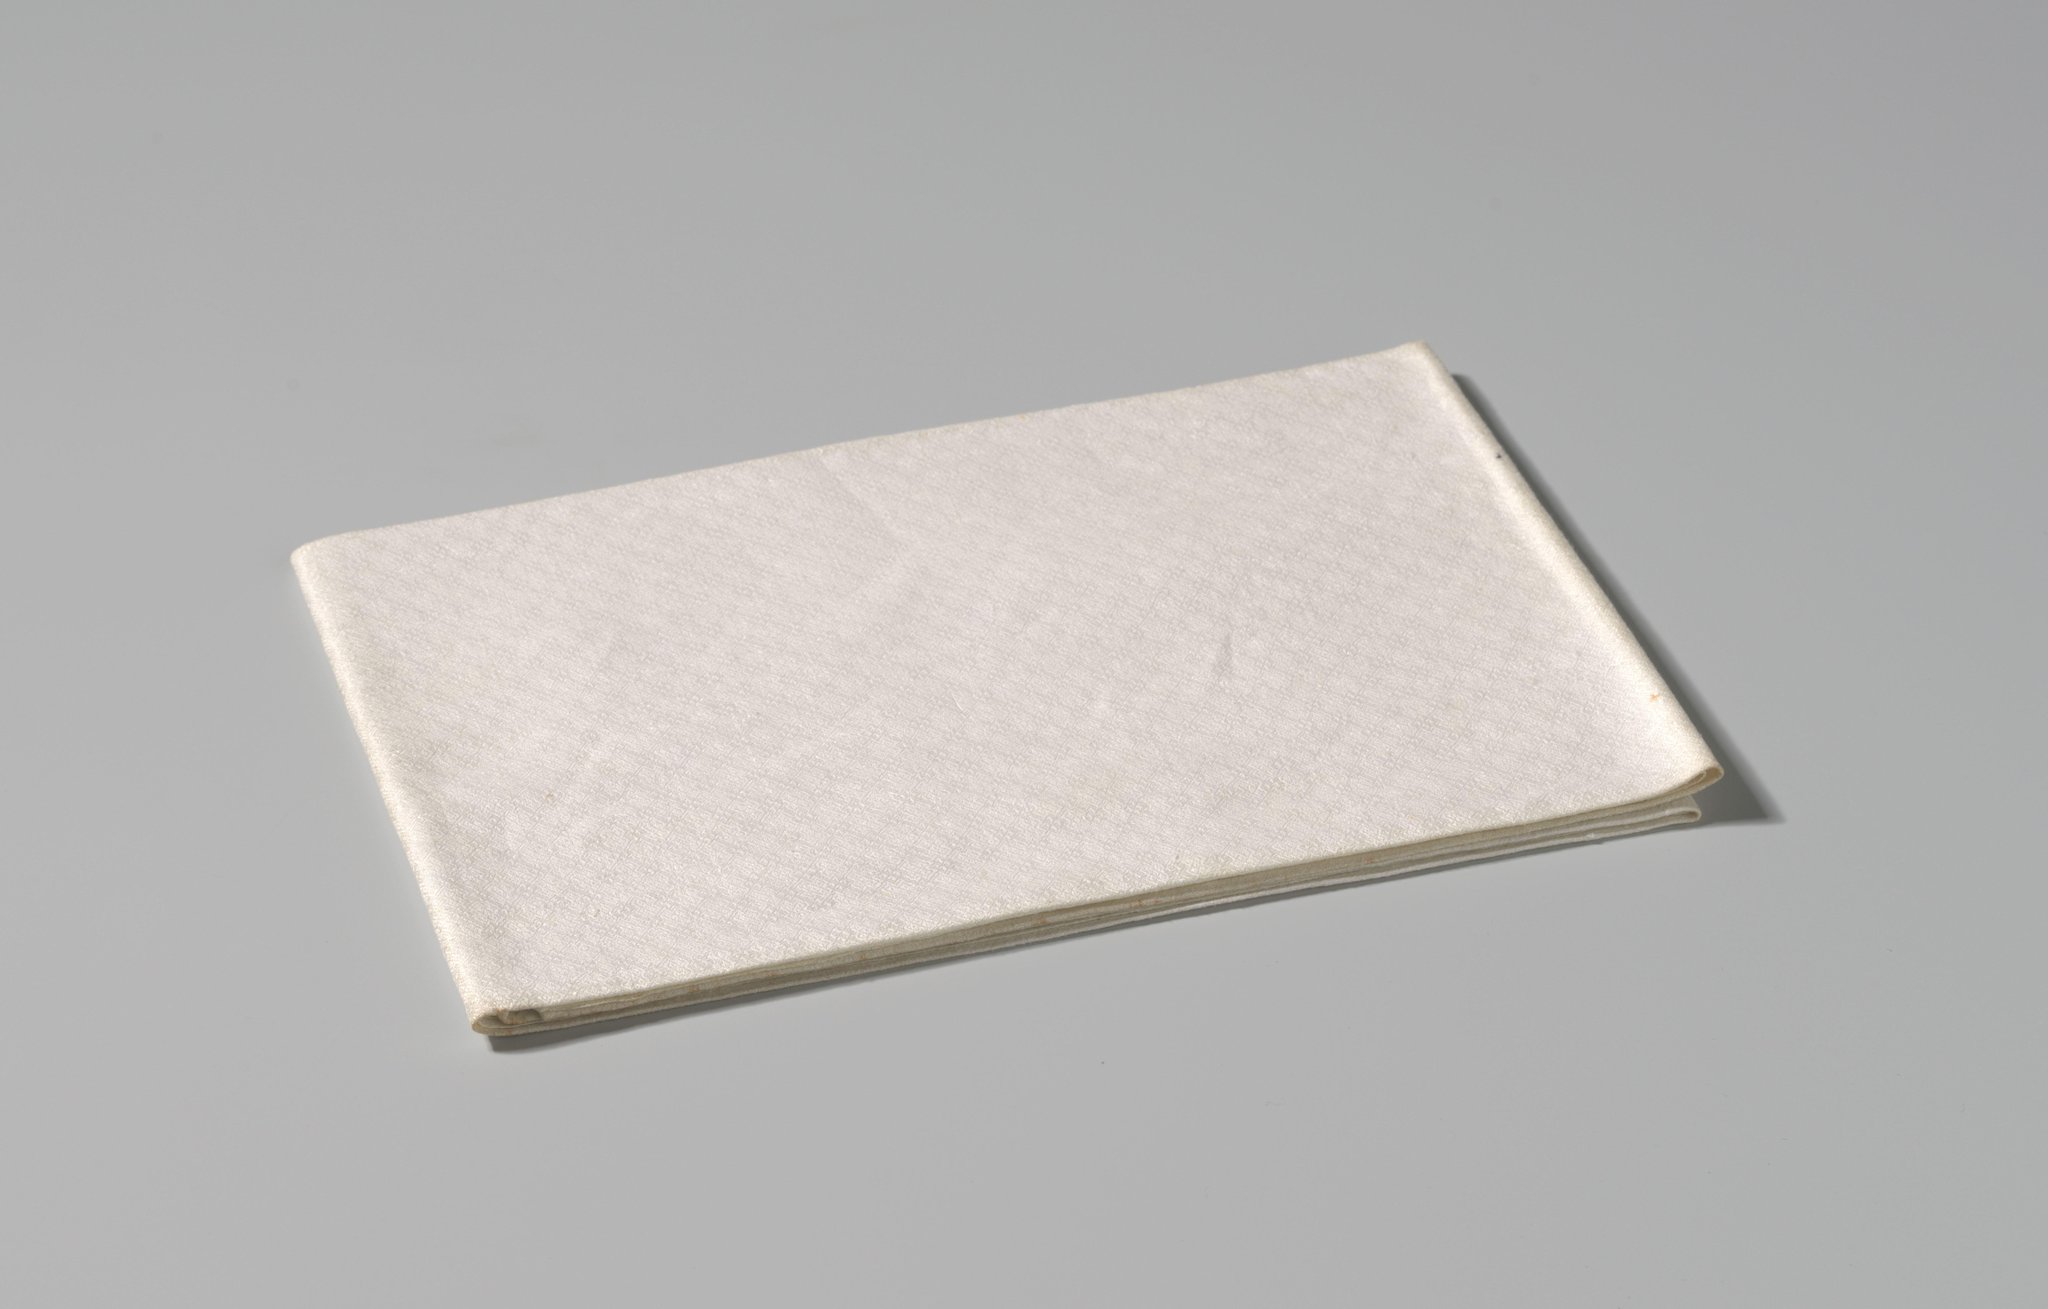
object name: napkin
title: Servet van wit linnen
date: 1600-1650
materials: linen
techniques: weave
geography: northern netherlands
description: Wit linnen servet met 'kruiswerk'patroon, merk HW 24.